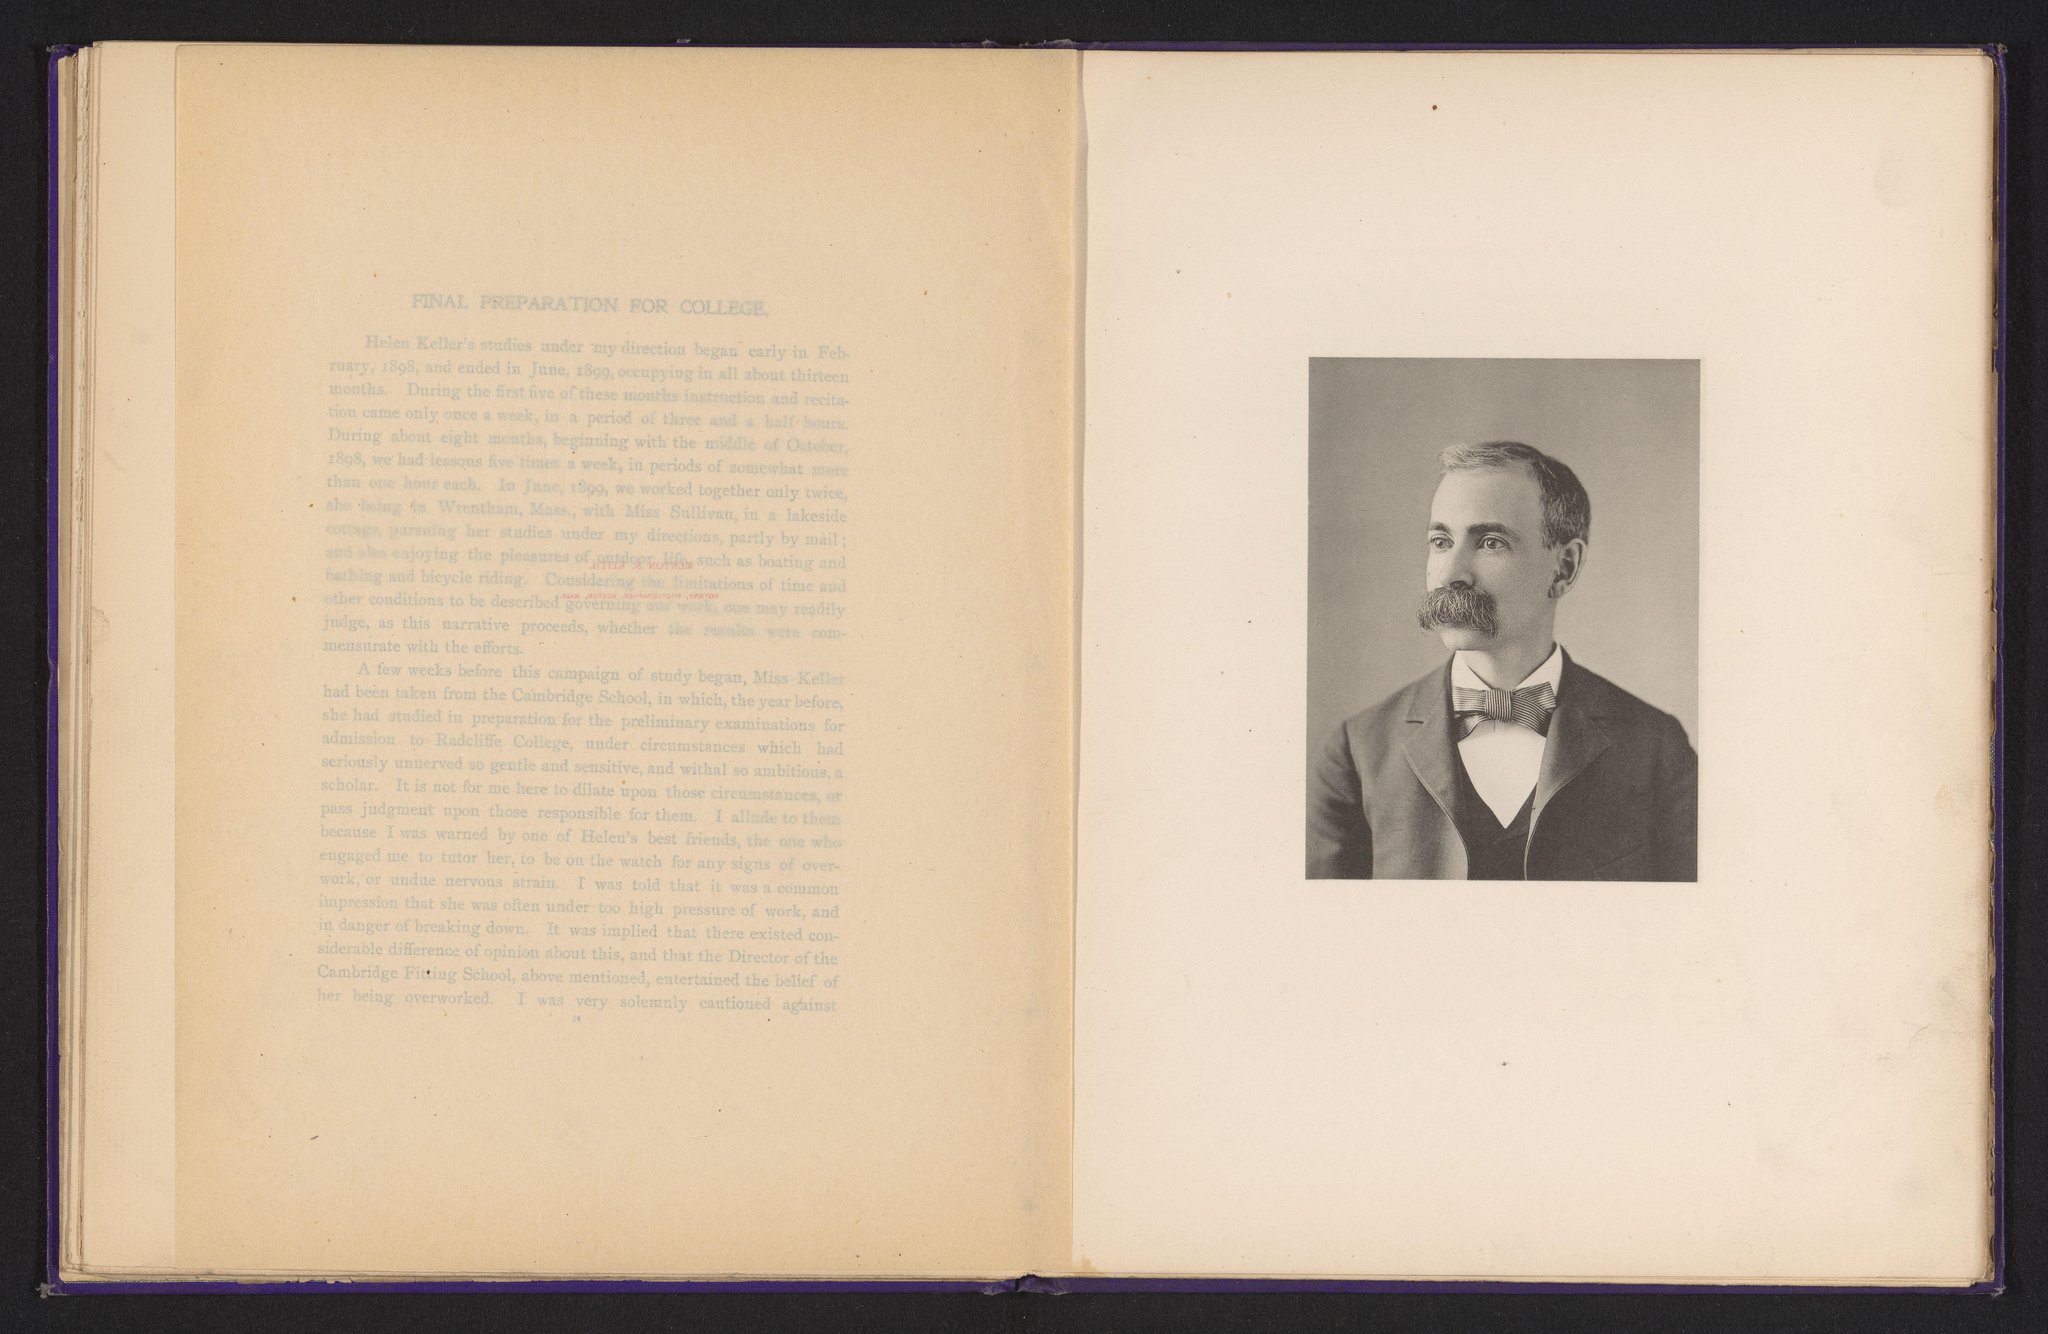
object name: page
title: Portret van Merton S. Keith, een docent van Helen Keller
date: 1885-1891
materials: paper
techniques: photograph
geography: boston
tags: adult man